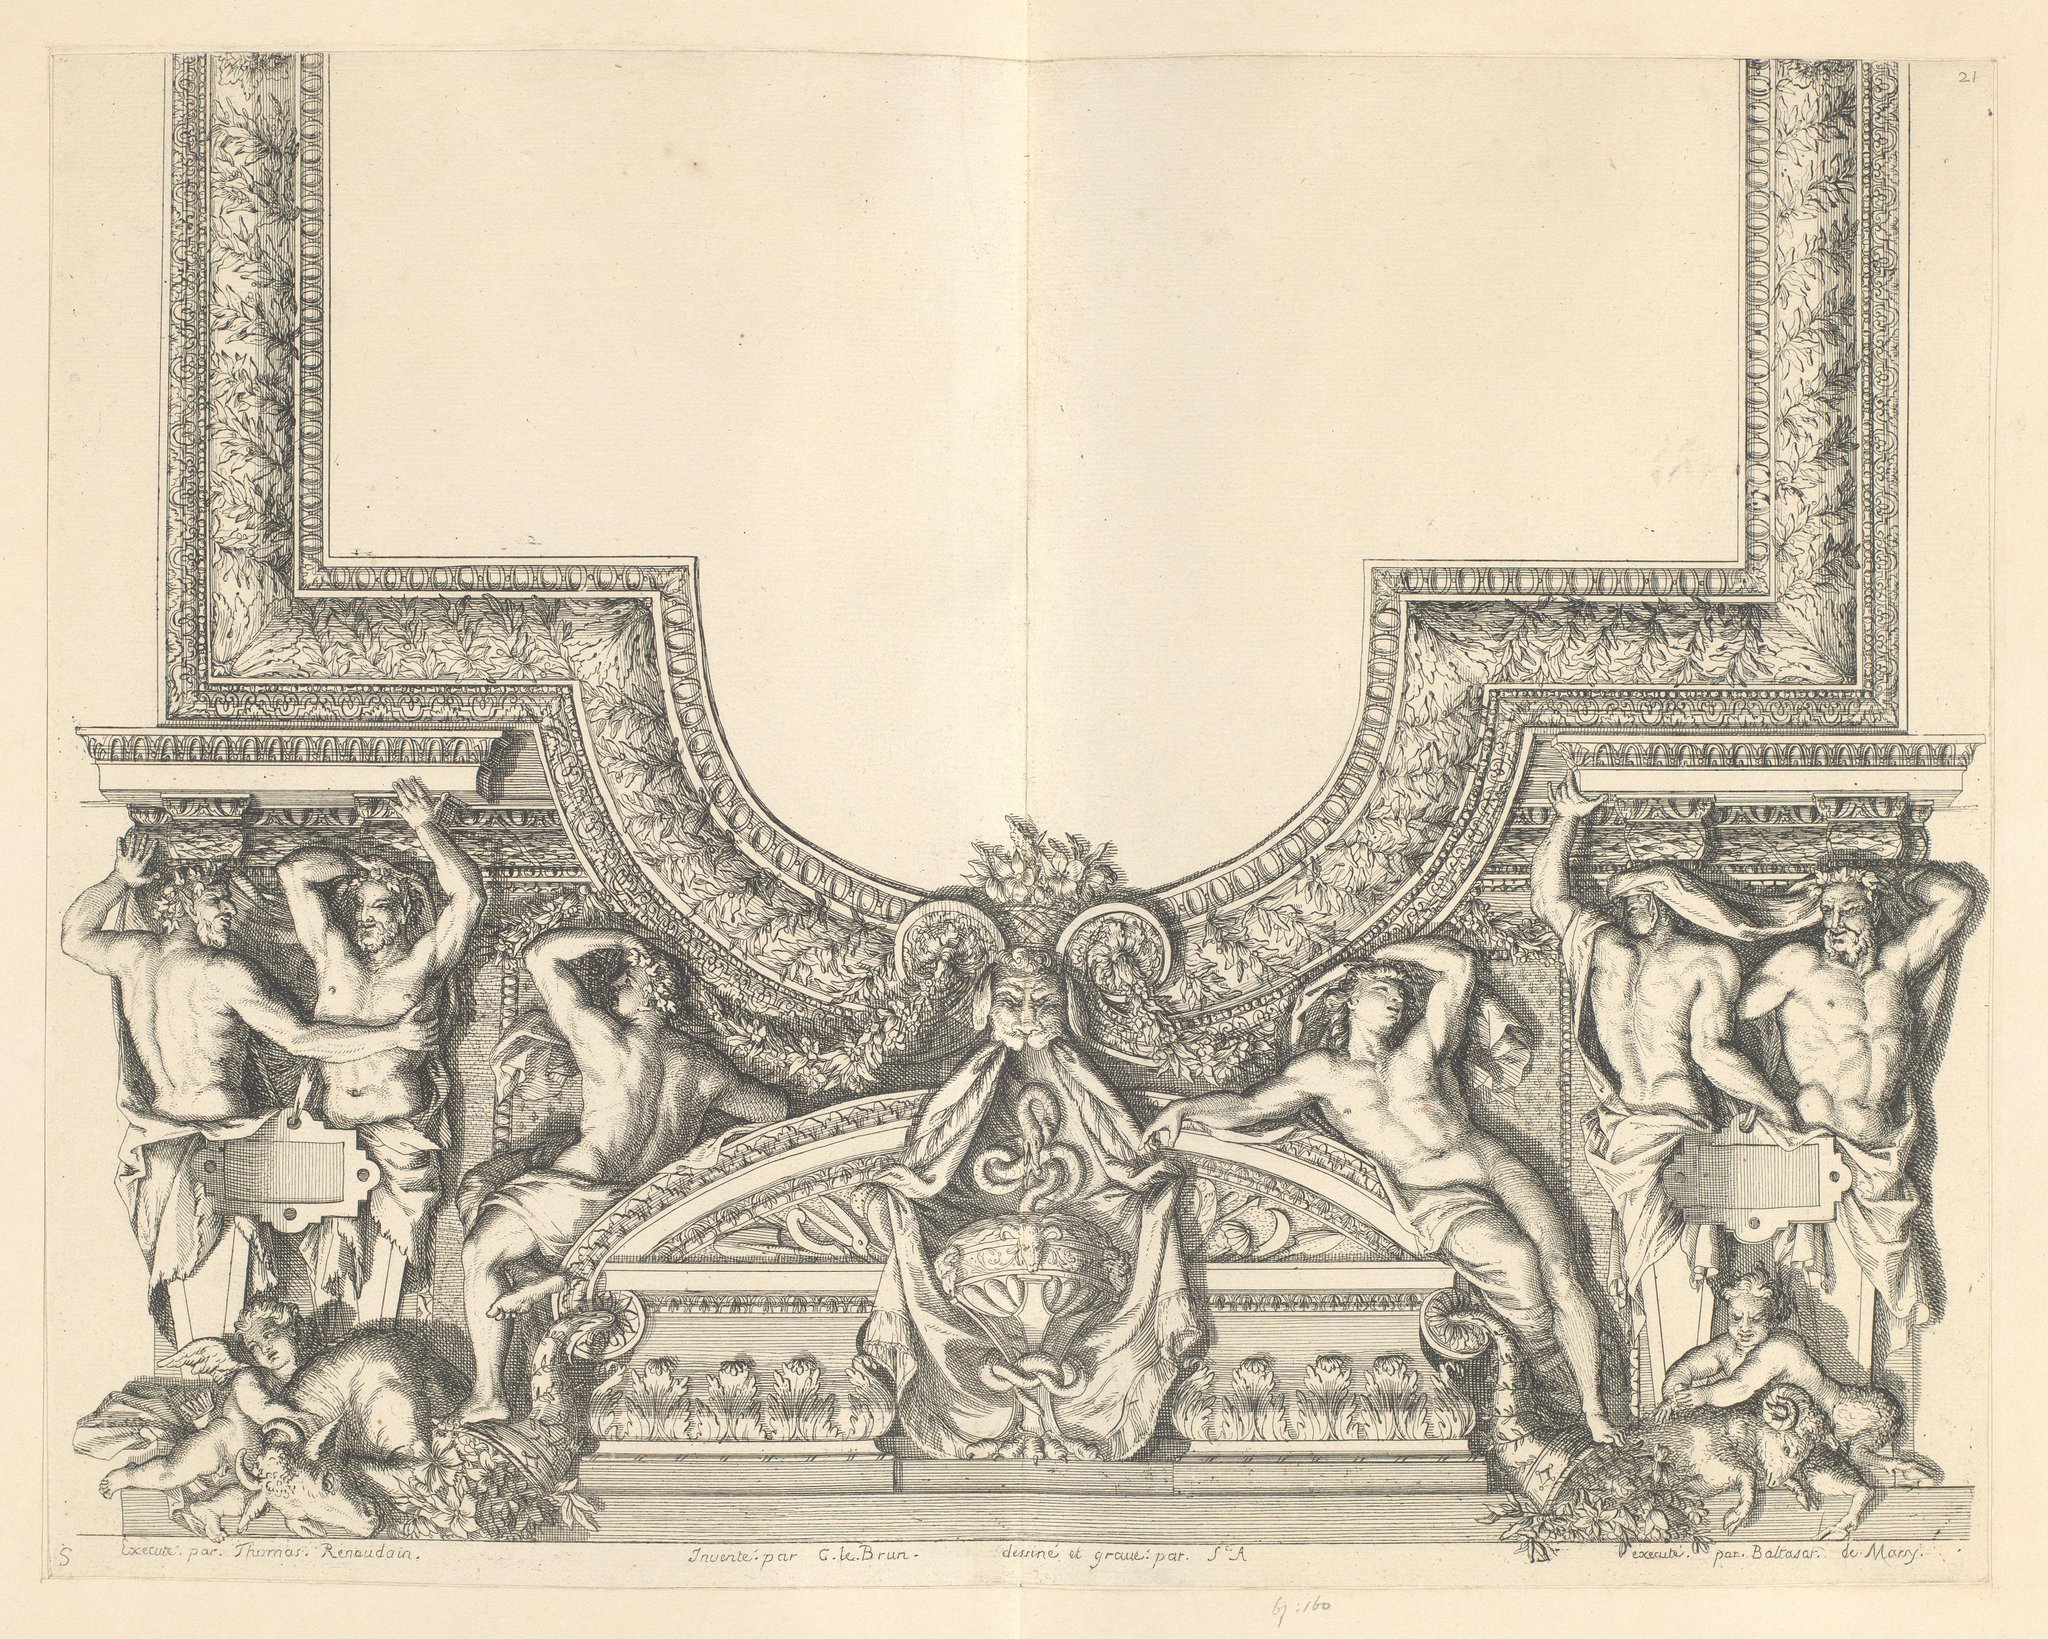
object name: print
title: La Petite Gallerie du Louvre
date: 1695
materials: paper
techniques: etching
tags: 'cornucopia', horn of plenty, ornaments ~ art, satyr(s) (in general), (decorated) ceiling, cupids: 'amores', 'amoretti', 'putti'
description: Gedecoreerd met onder andere hermen, twee naakte figuren, een putto met een stier, een satyr met een ram, en cornucopia. Deze prent maakt deel uit van een album.